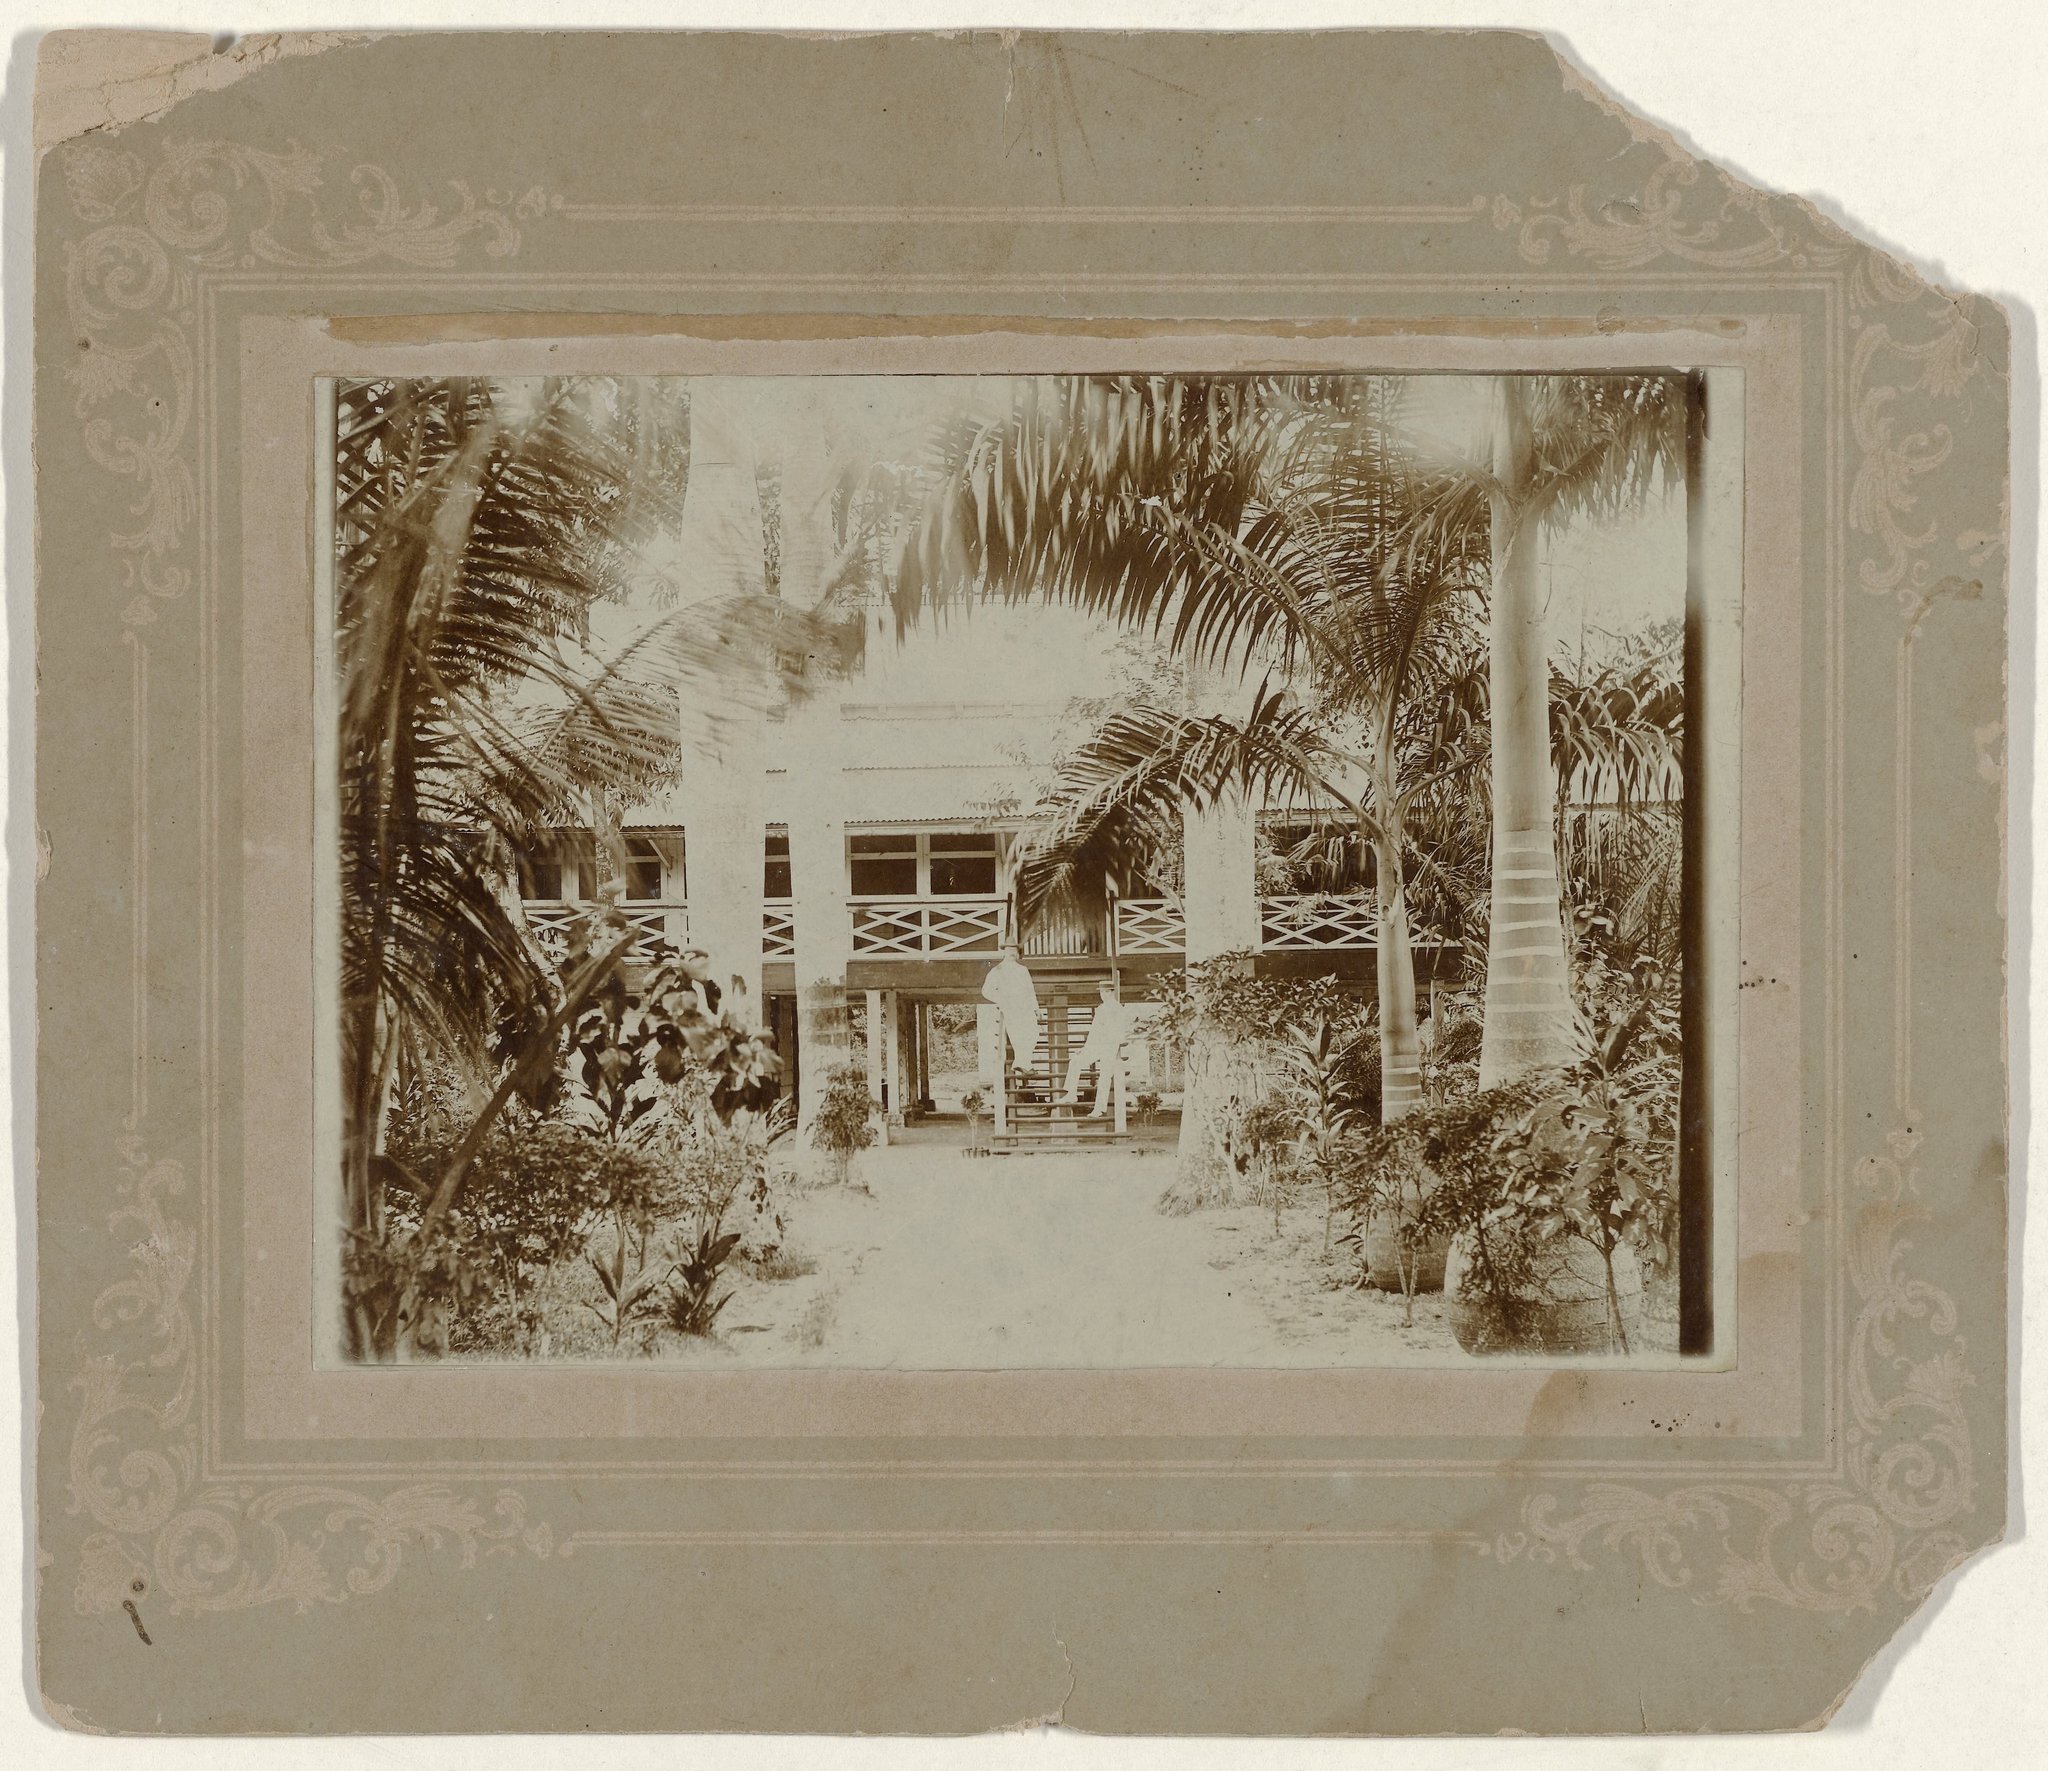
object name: photograph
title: Twee mannen staan op de trap van vermoedelijk de plantagewoning Morgenstond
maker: w.w. schroeder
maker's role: fotograaf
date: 1900-1910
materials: cardboard, photographic support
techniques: photography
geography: suriname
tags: suriname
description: Twee mannen op een trap van een plantagewoning, vermoedelijk de plantagewoning Morgenstond. Onderdeel van een groep foto's van de familie Boom-Gonggrijp in Suriname.